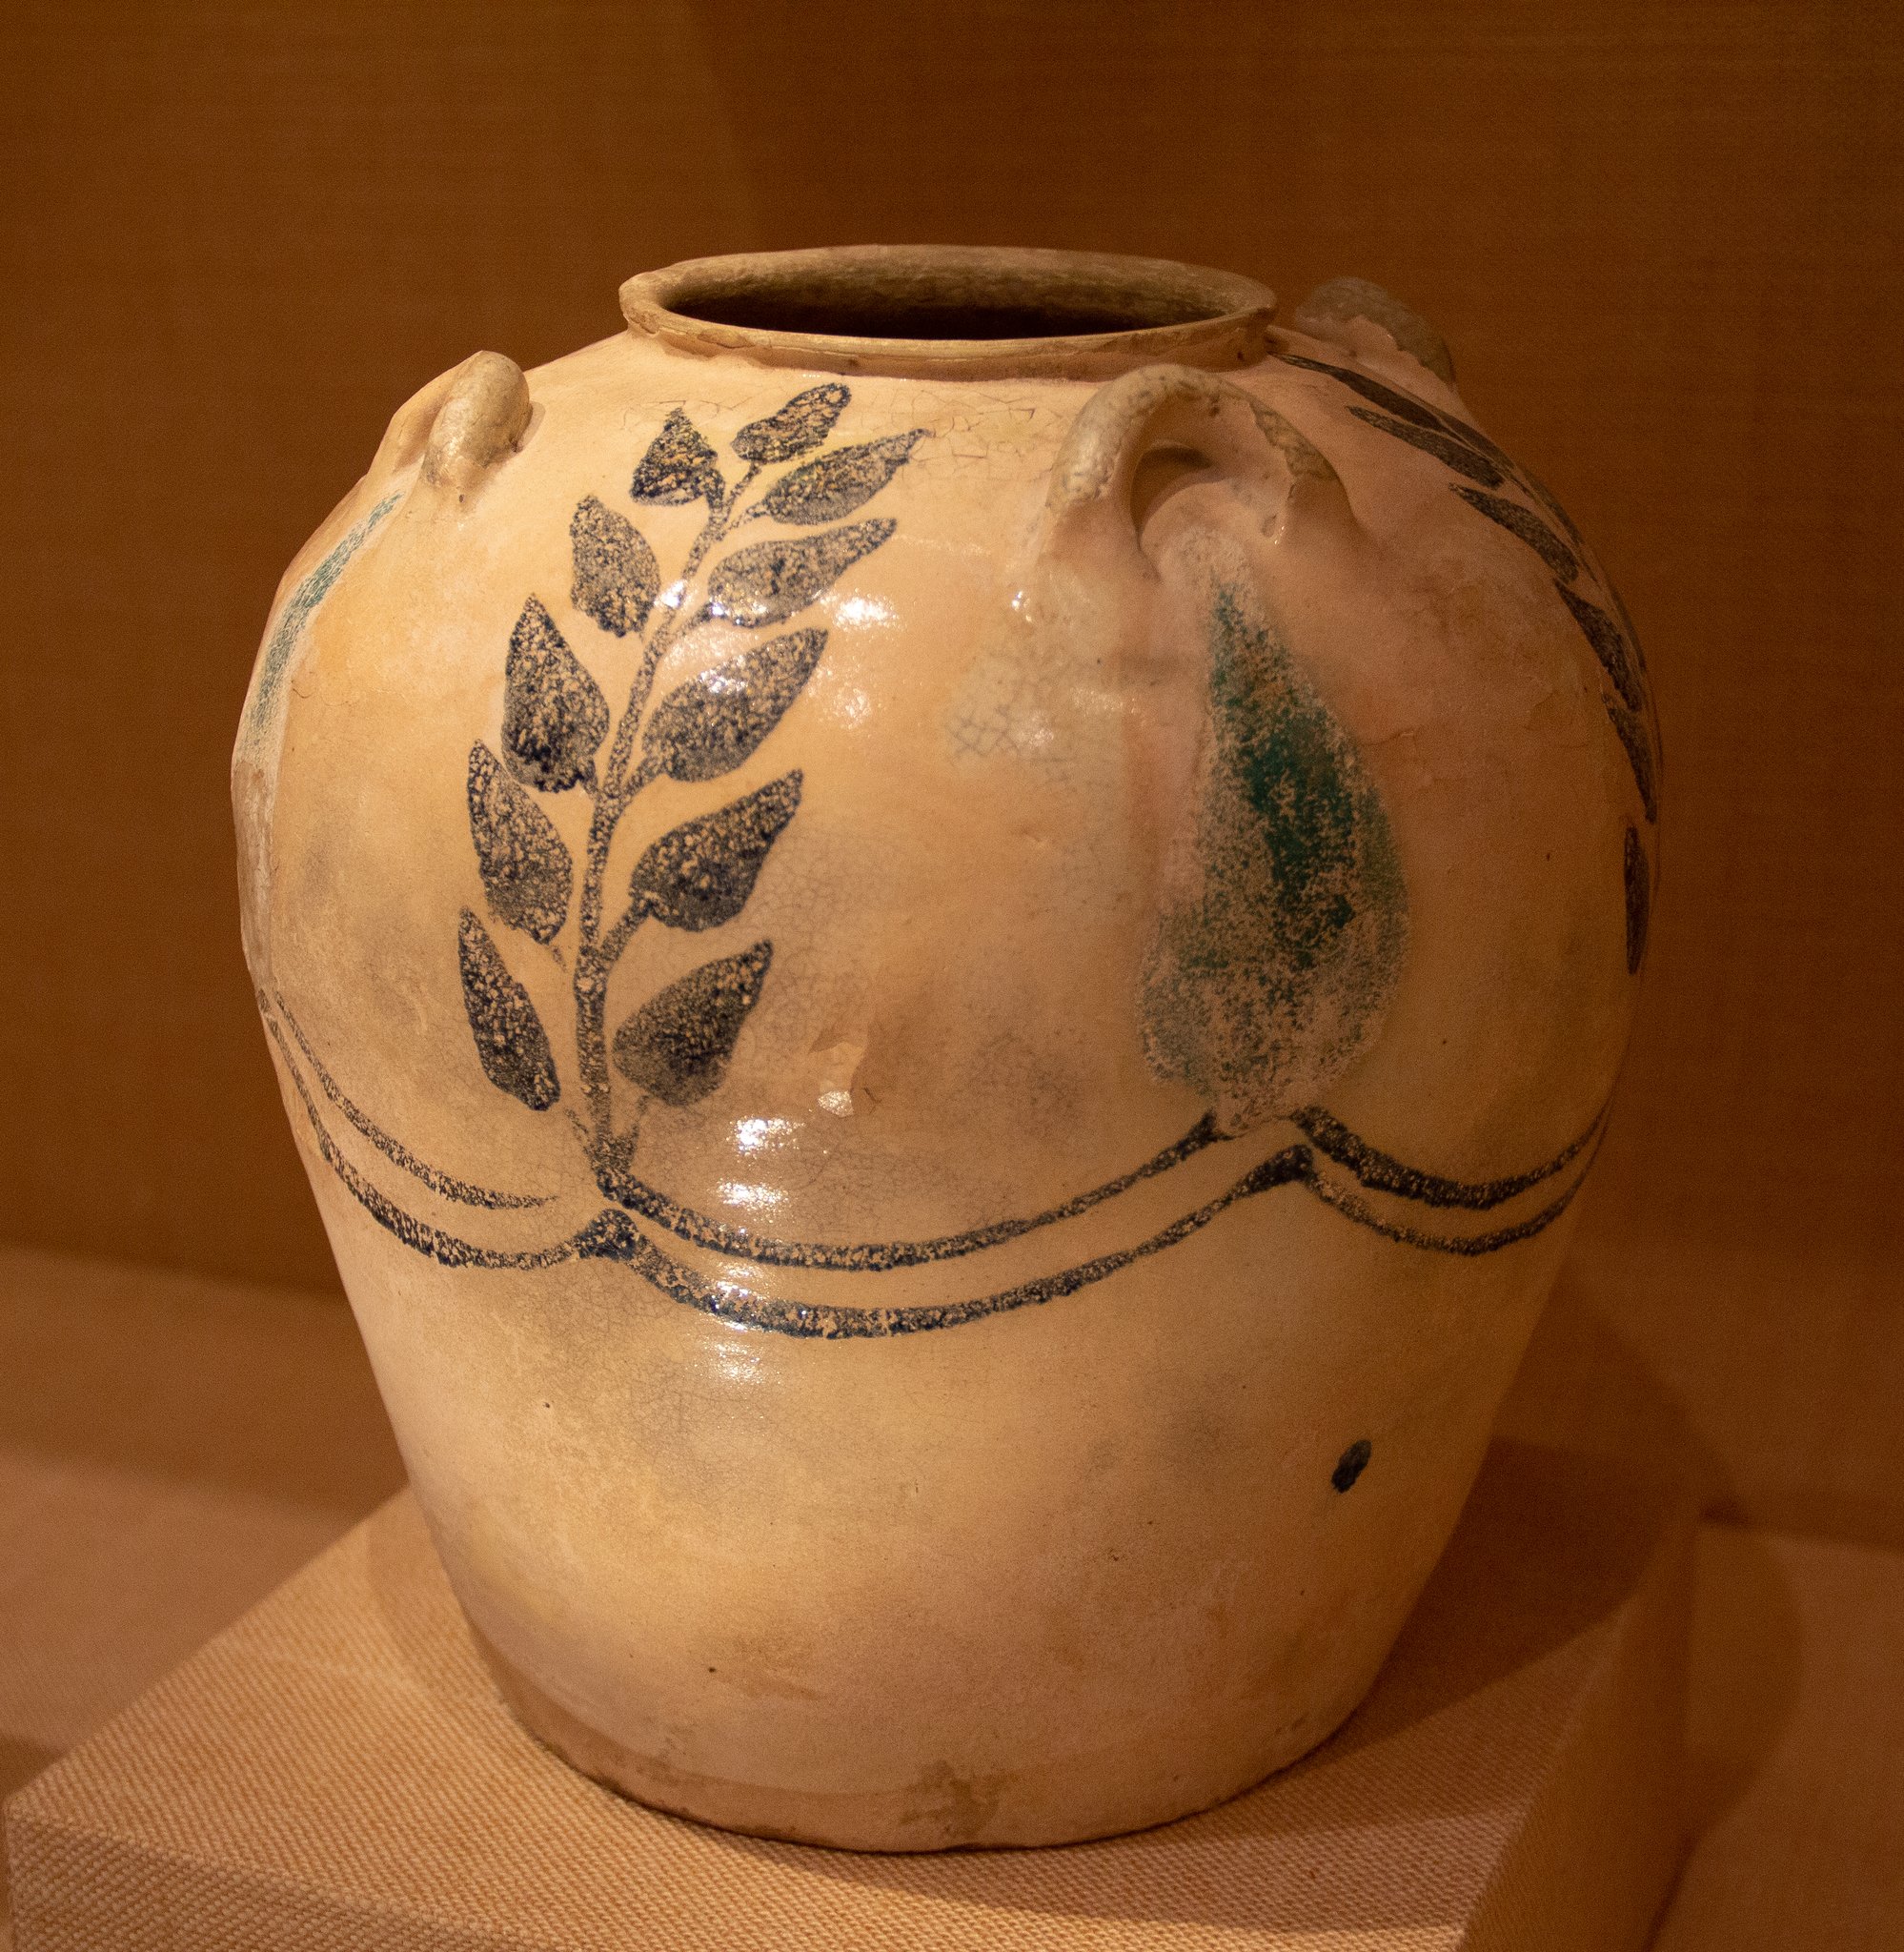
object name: jar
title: Jar with Four Lug Handles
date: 801-900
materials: earthenware, glaze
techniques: painting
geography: iran